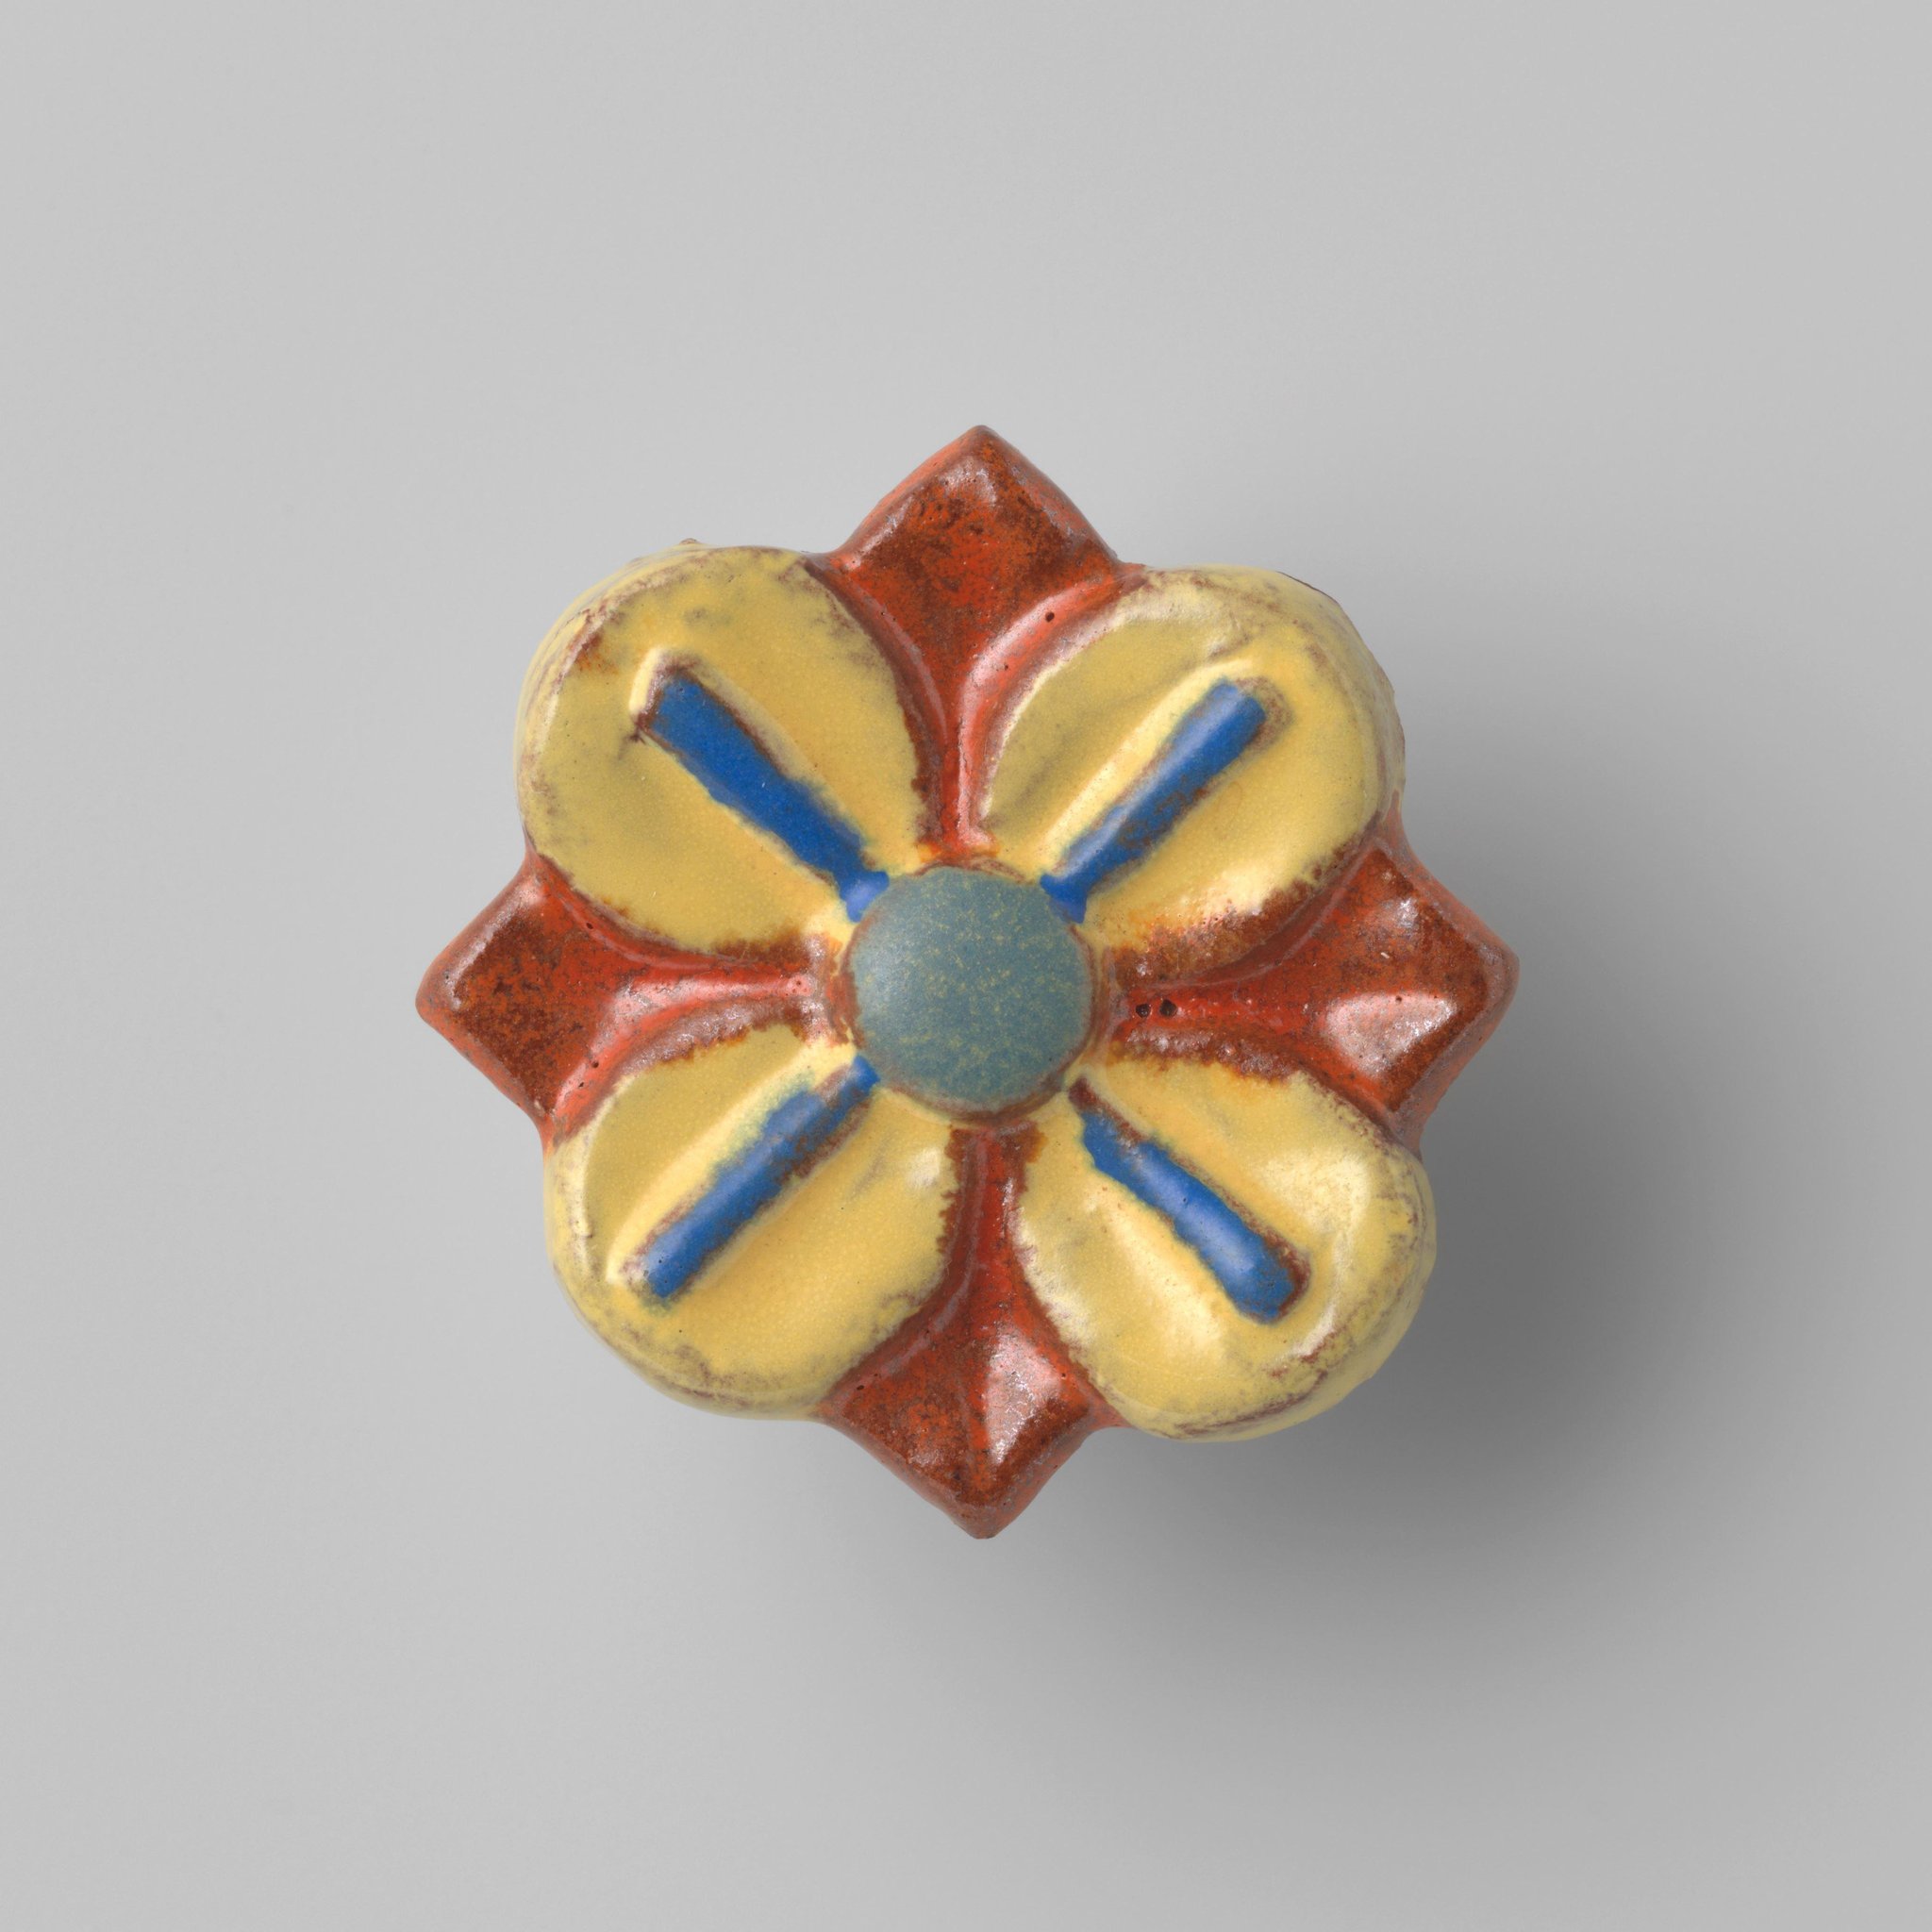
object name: brooch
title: Broche van keramiek met een bloem in een vierkant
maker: Anonymous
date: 1900-1990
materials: ceramic, metal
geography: tegelen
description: Broche van keramiek met een bloem met blauwe blaadjes en een groen hart in een rood vierkant voorzien van een opgelijmde haaksluiting die over het merk aan de achterzijde is geplakt.